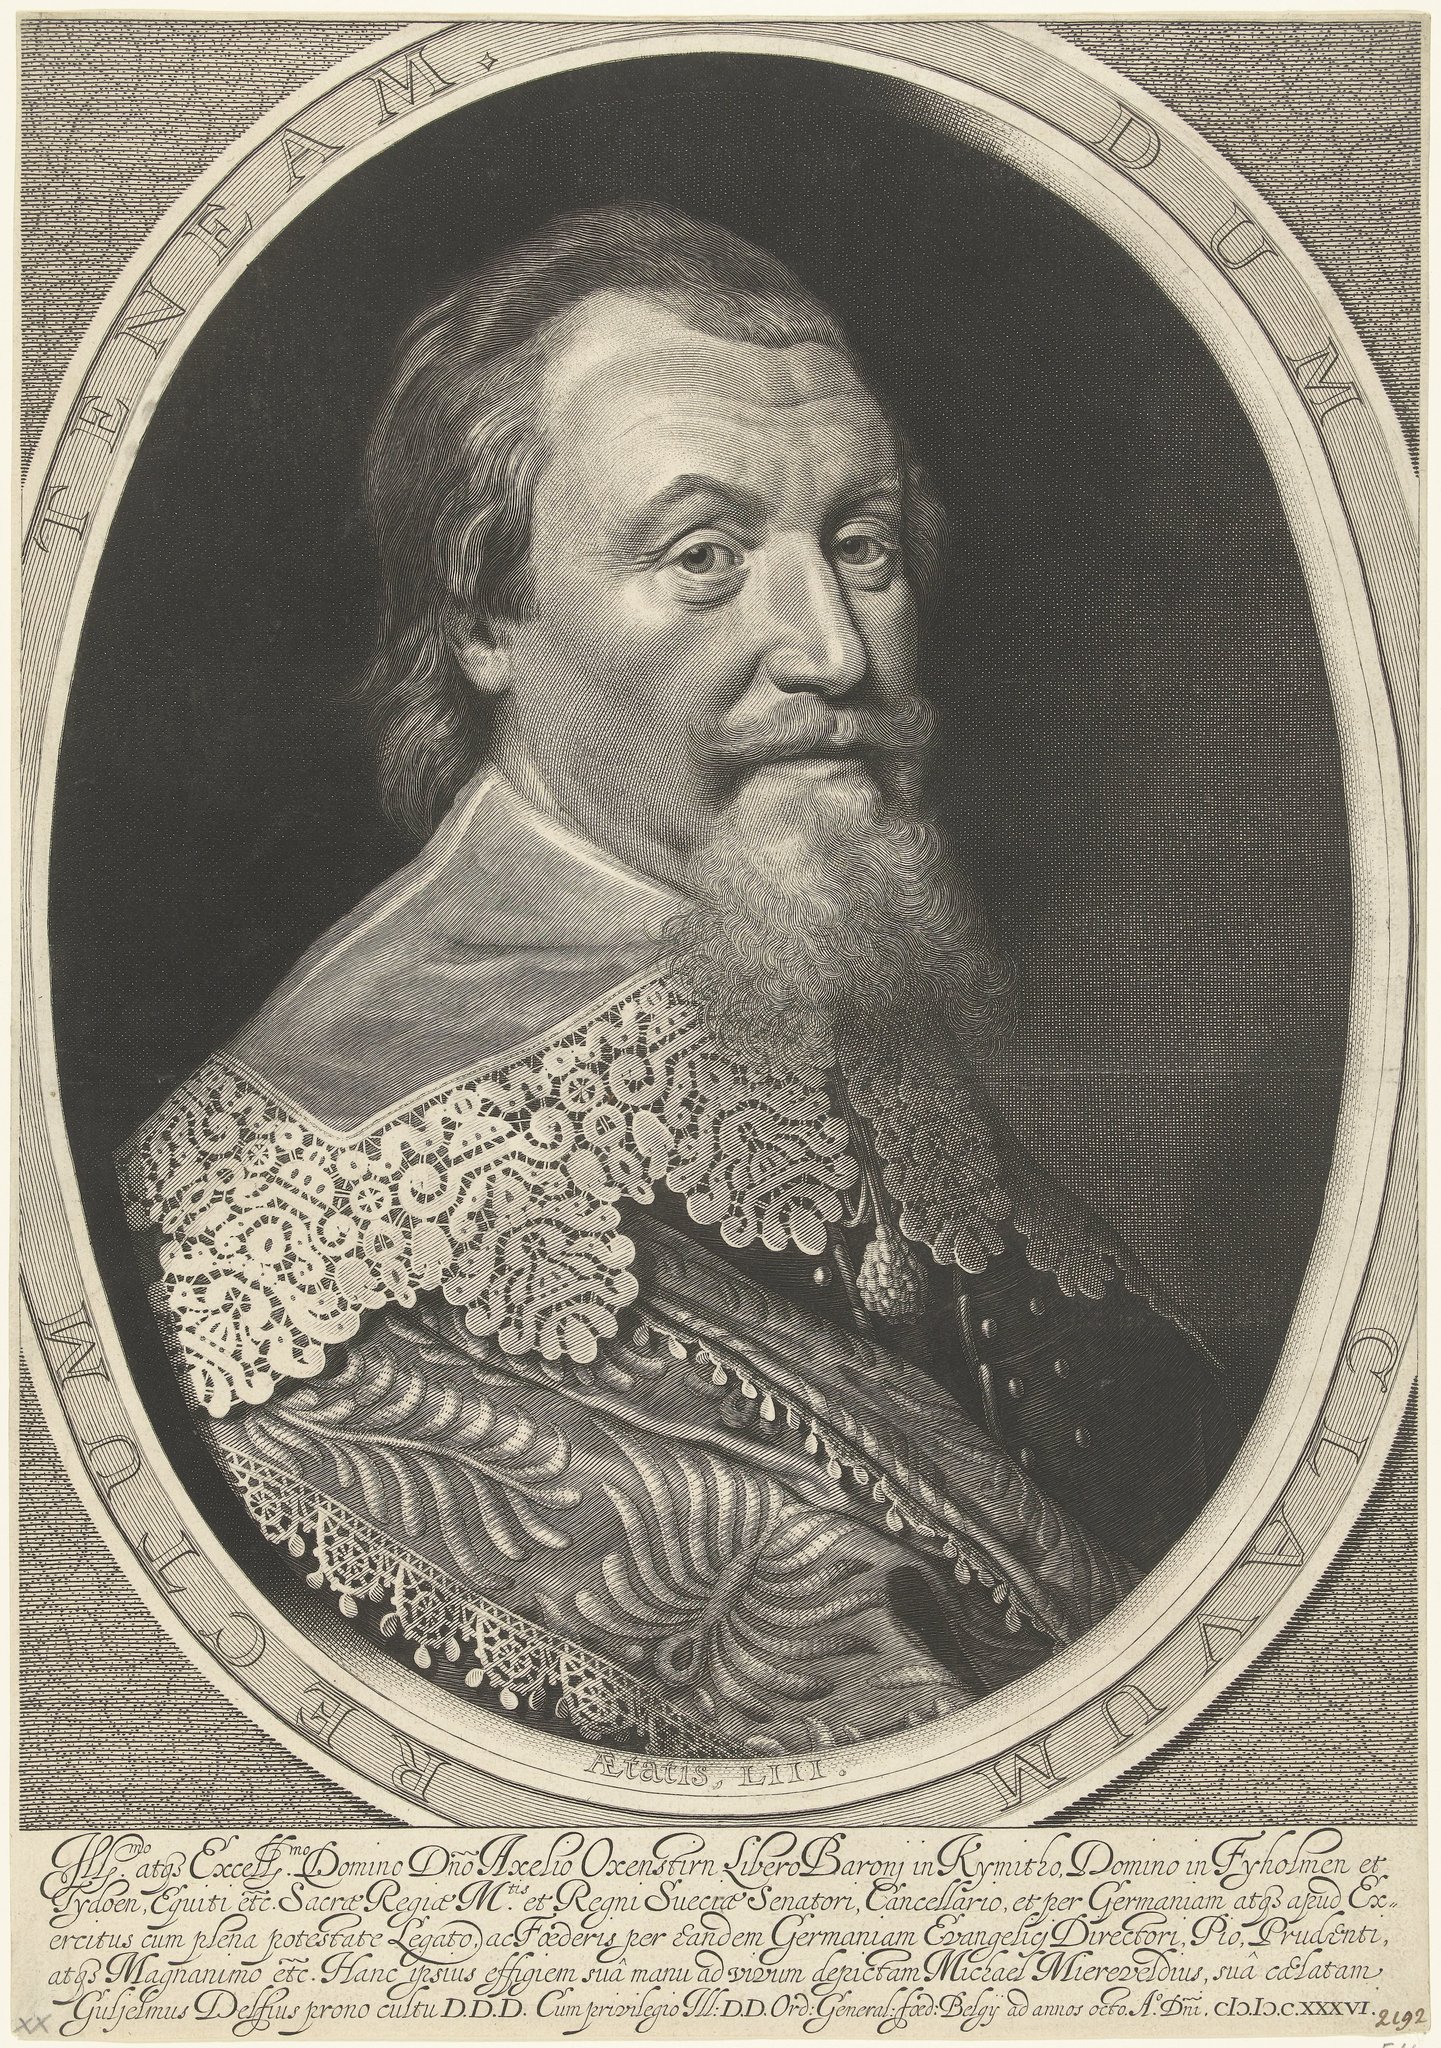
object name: print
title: Portret van Axel Oxenstierna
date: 1636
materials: paper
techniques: engraving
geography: delft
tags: official; civil servant; functionary (in general), historical persons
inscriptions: collector's mark: Lugt 2228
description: Portret van graaf Axel Oxenstierna, borststuk met kanten kraag in ovale omlijsting met Latijns motto. In ondermarge Latijns opschrift in vijf regels.